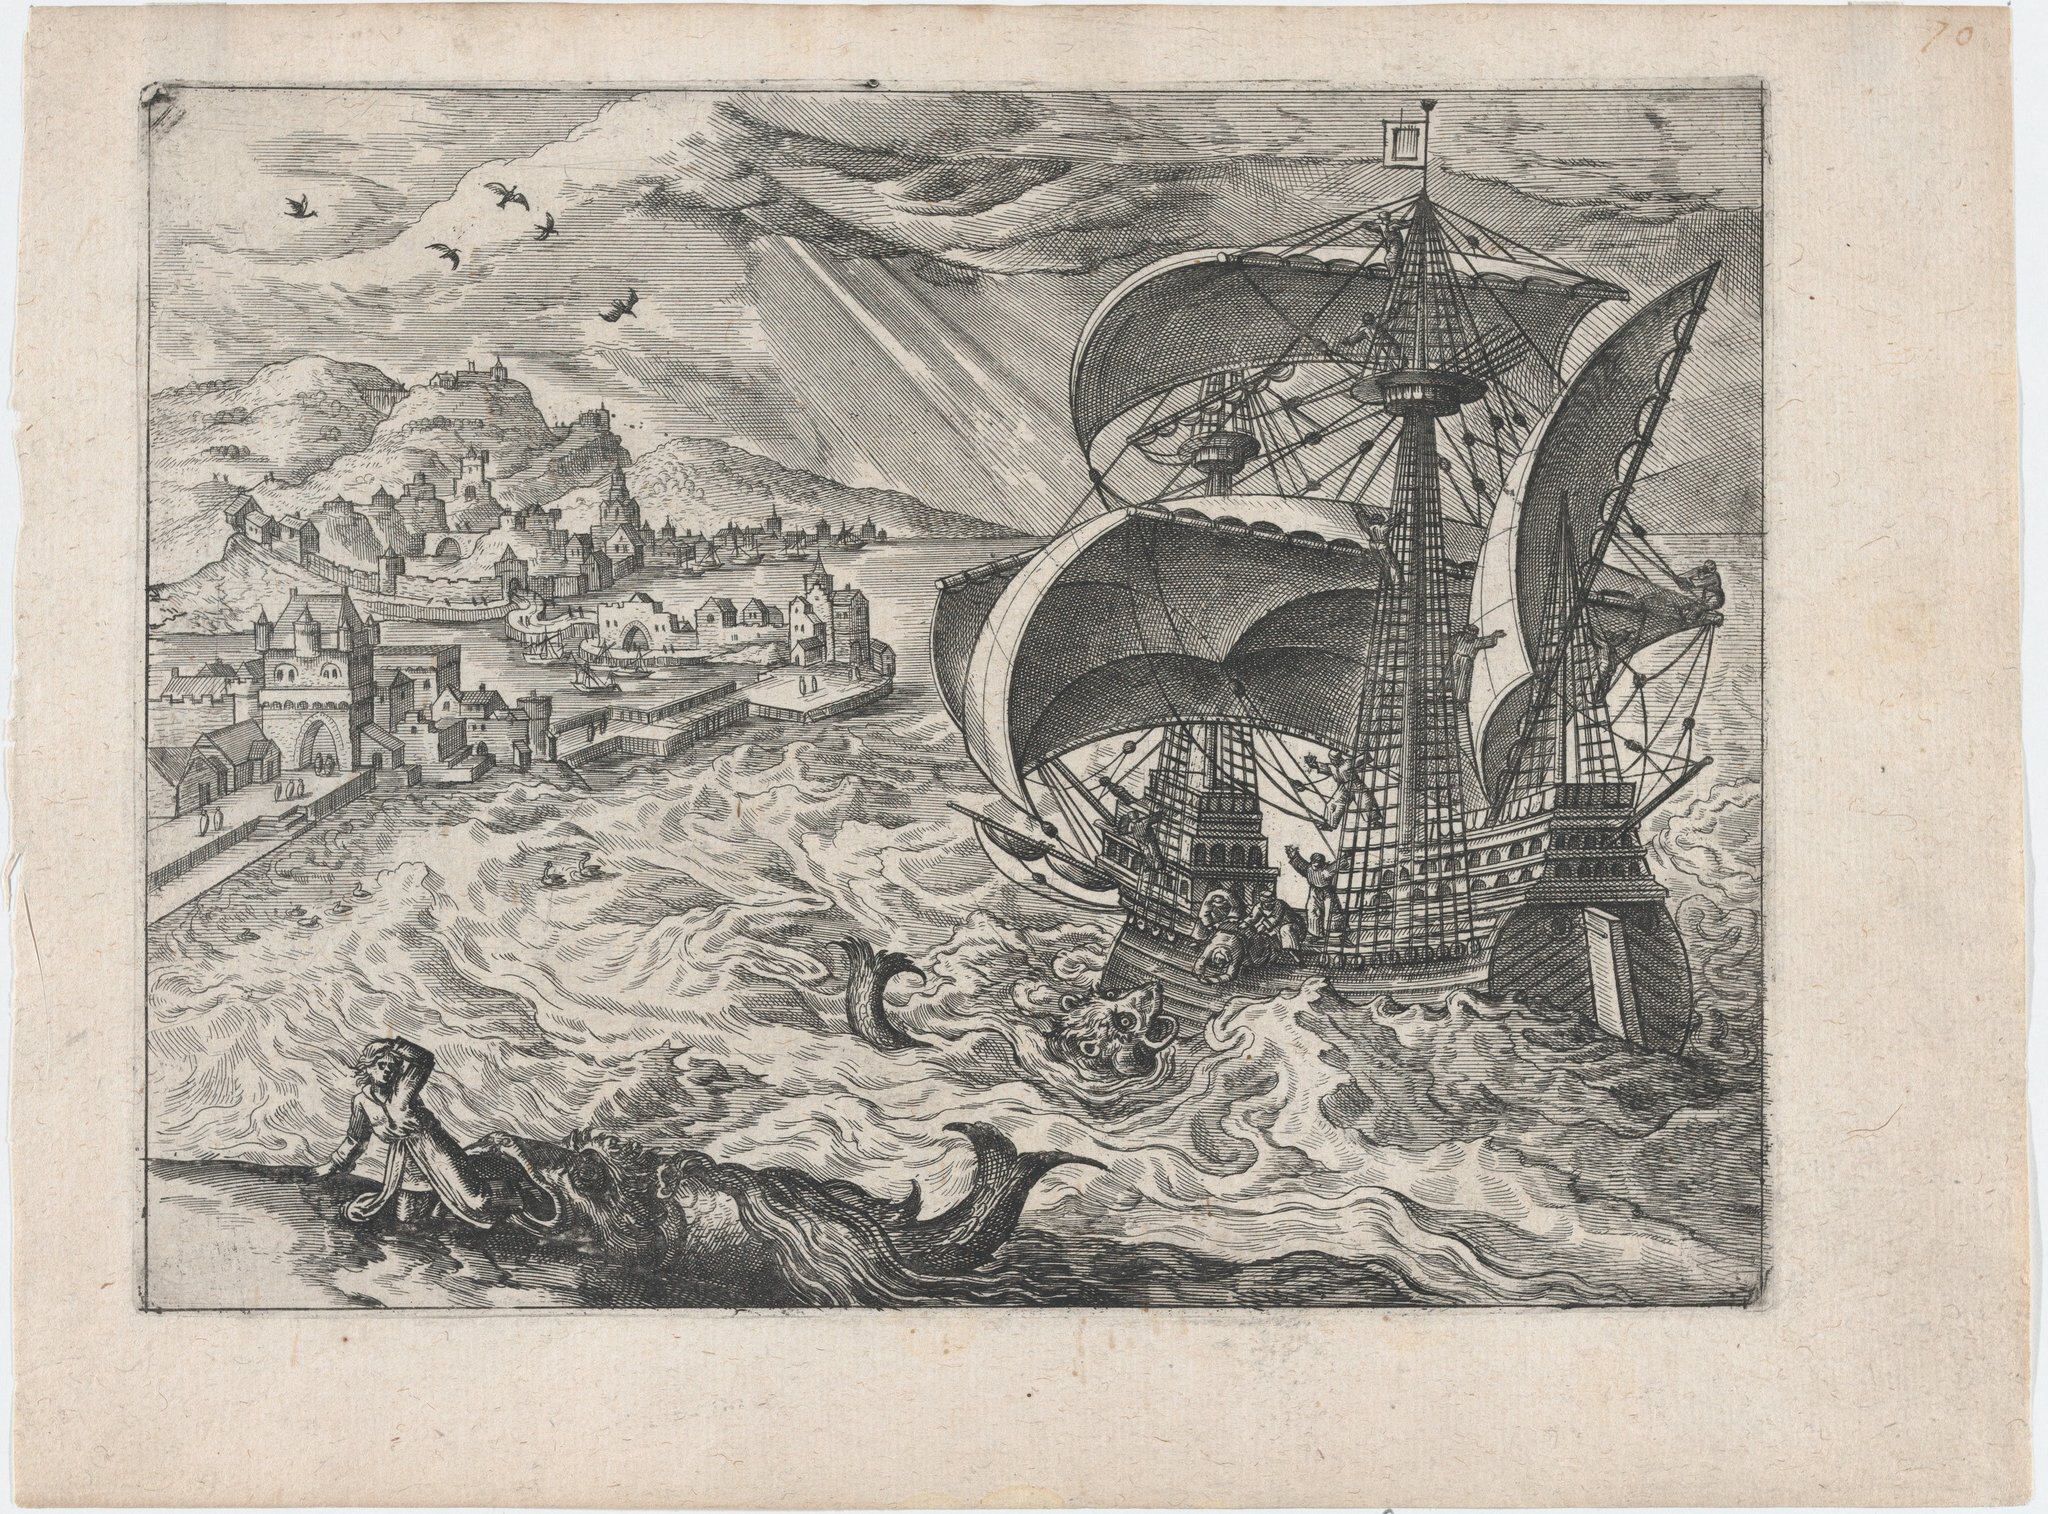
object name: print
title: Landscape with a Ship and Jonah and the Whale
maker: lucas gassel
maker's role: artist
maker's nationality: netherlandish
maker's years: 1495-1500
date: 1560-1570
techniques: engraving, etching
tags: whales,landscapes,ships